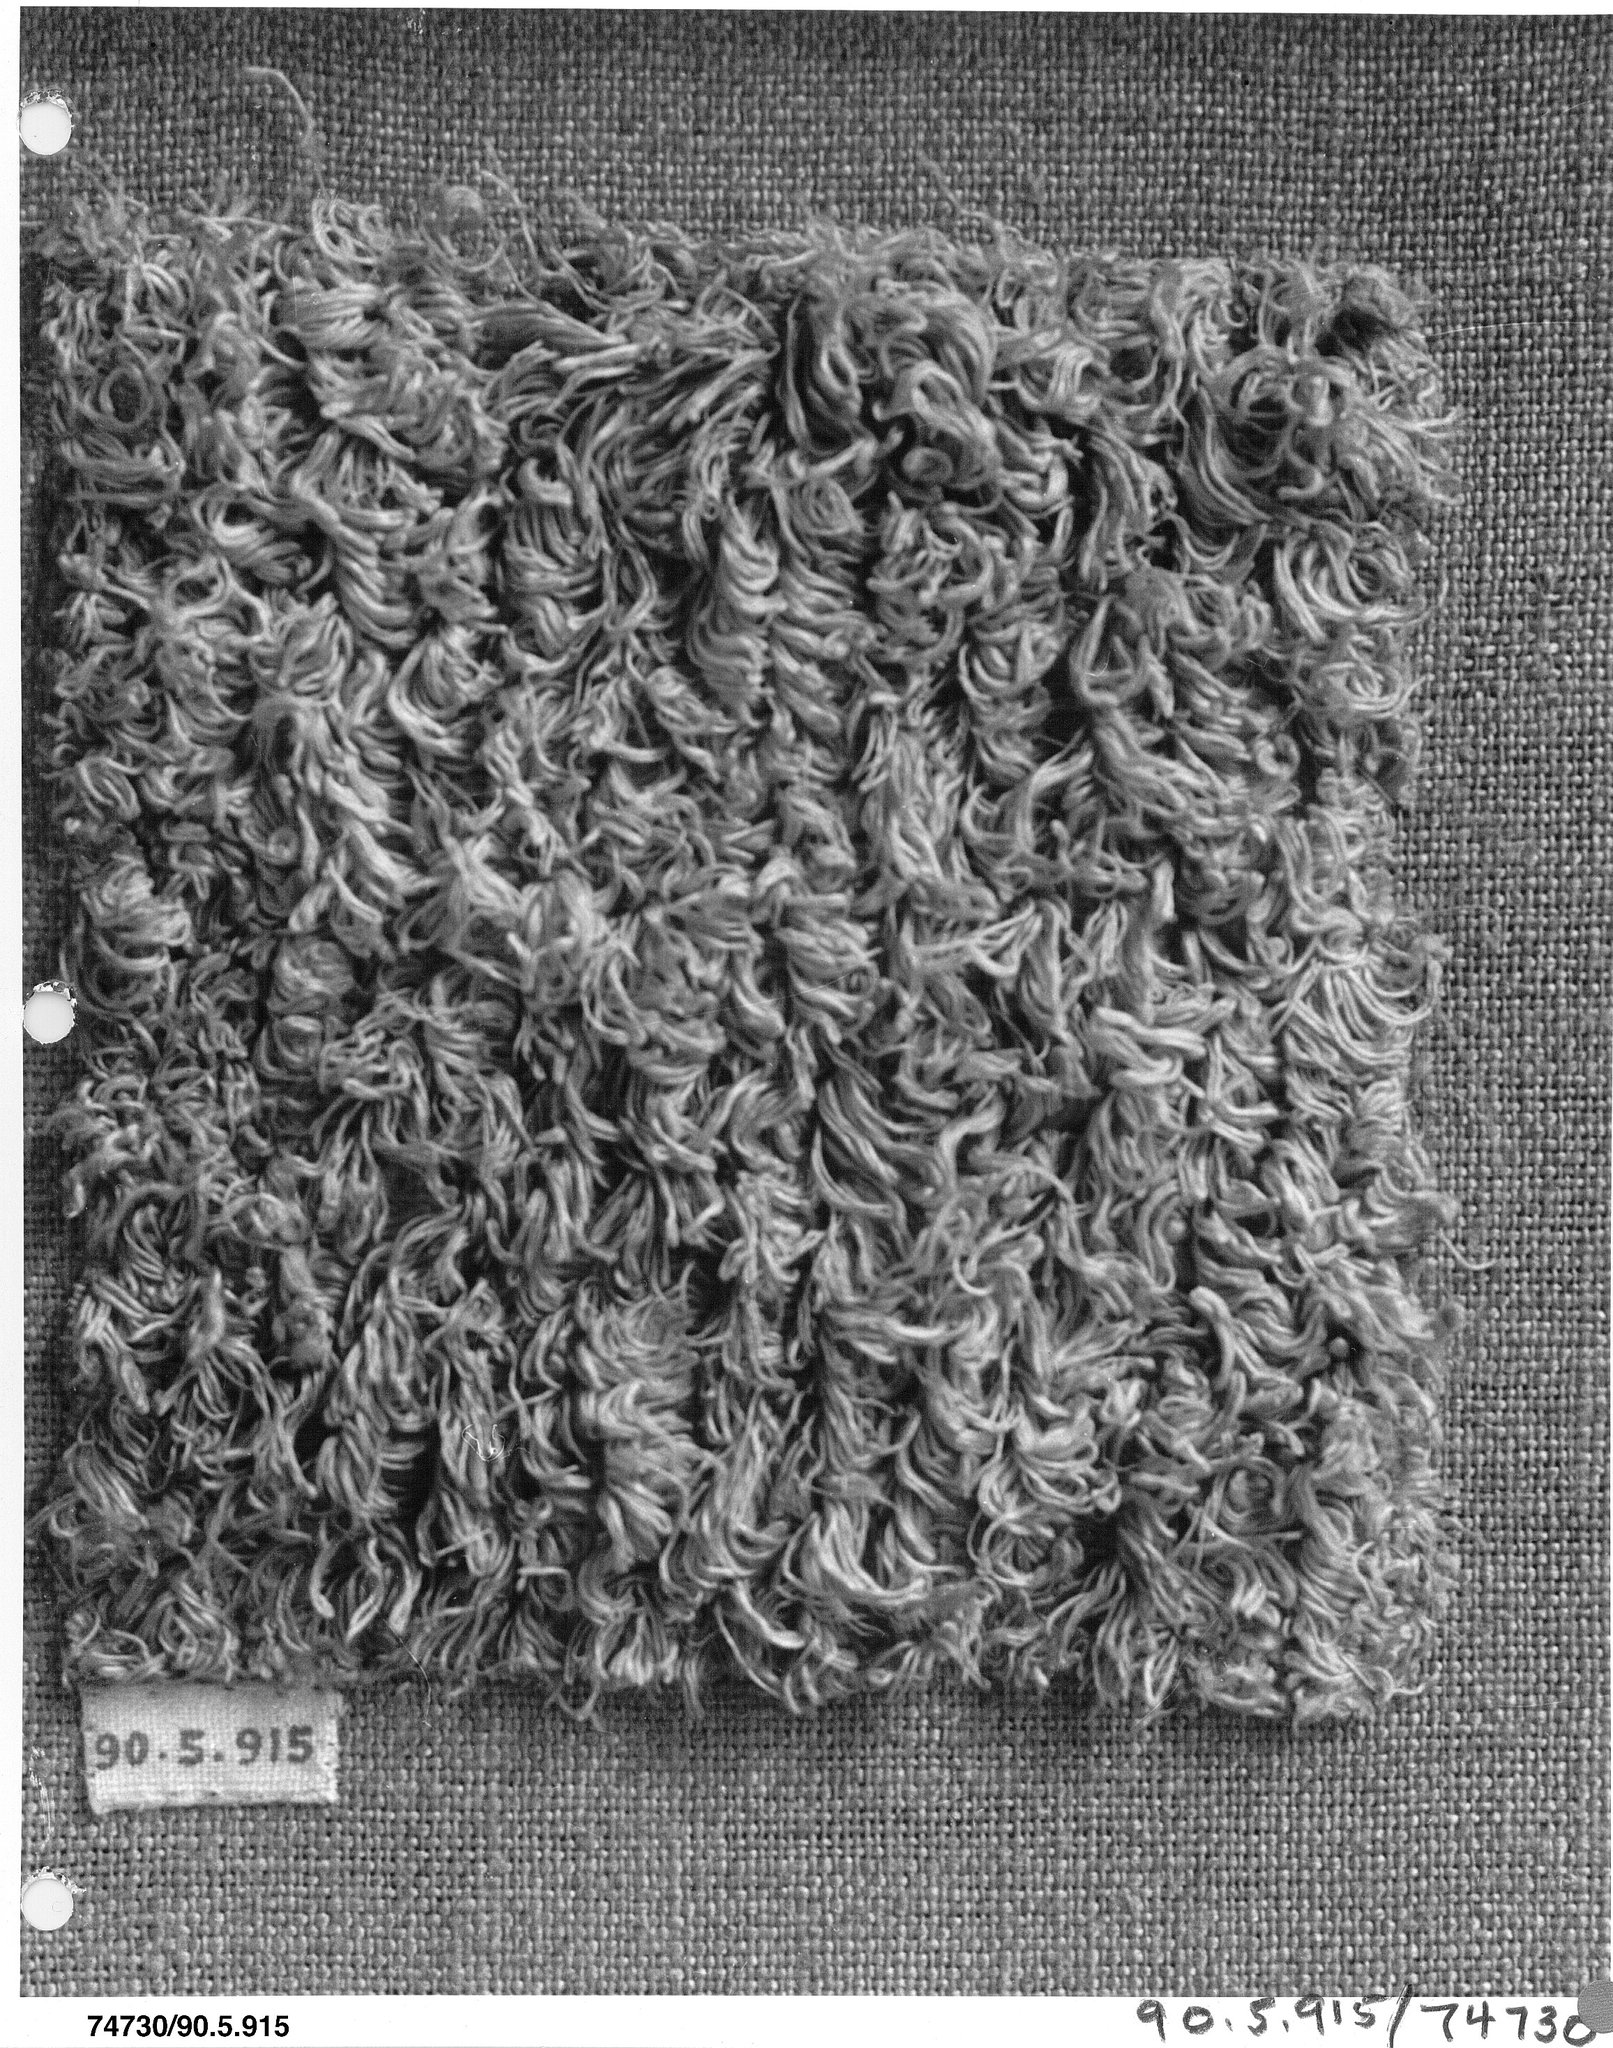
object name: textile fragment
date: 201-400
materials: linen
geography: egypt